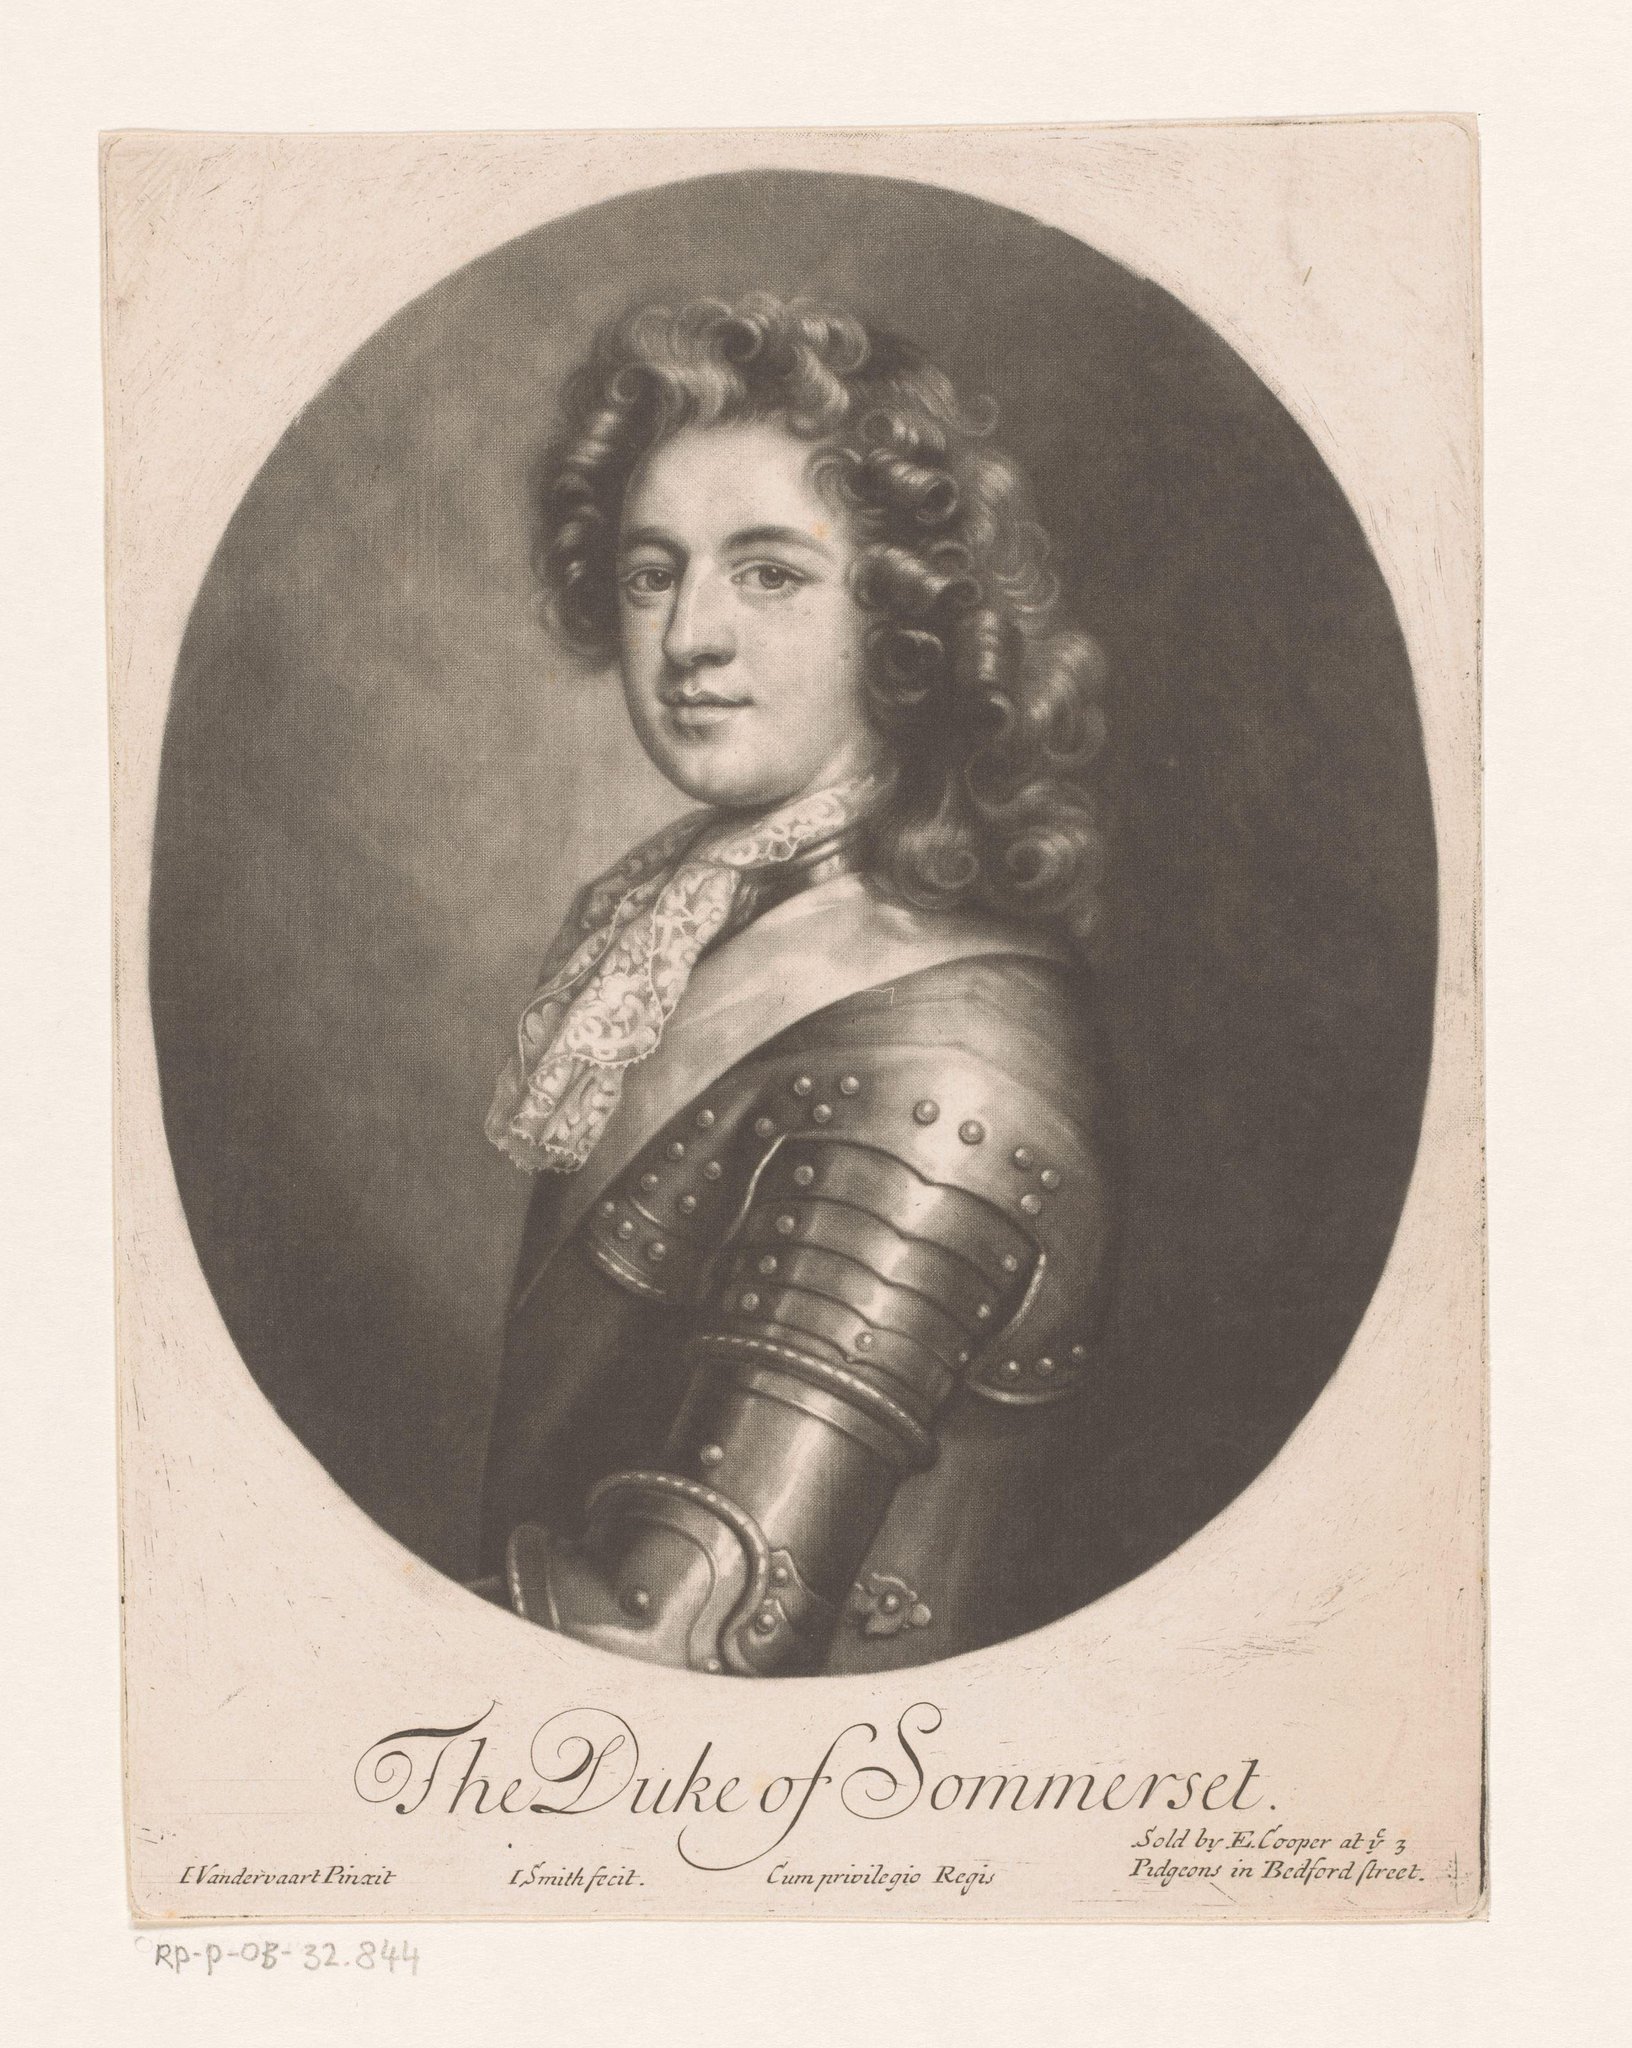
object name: print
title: Portret van Charles Seymour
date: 1686-1725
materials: paper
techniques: mezzotint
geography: england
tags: charles seymour (6e hertog van somerset), jury, historical persons, politician, e.g. party leader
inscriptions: collector's mark: Lugt 240